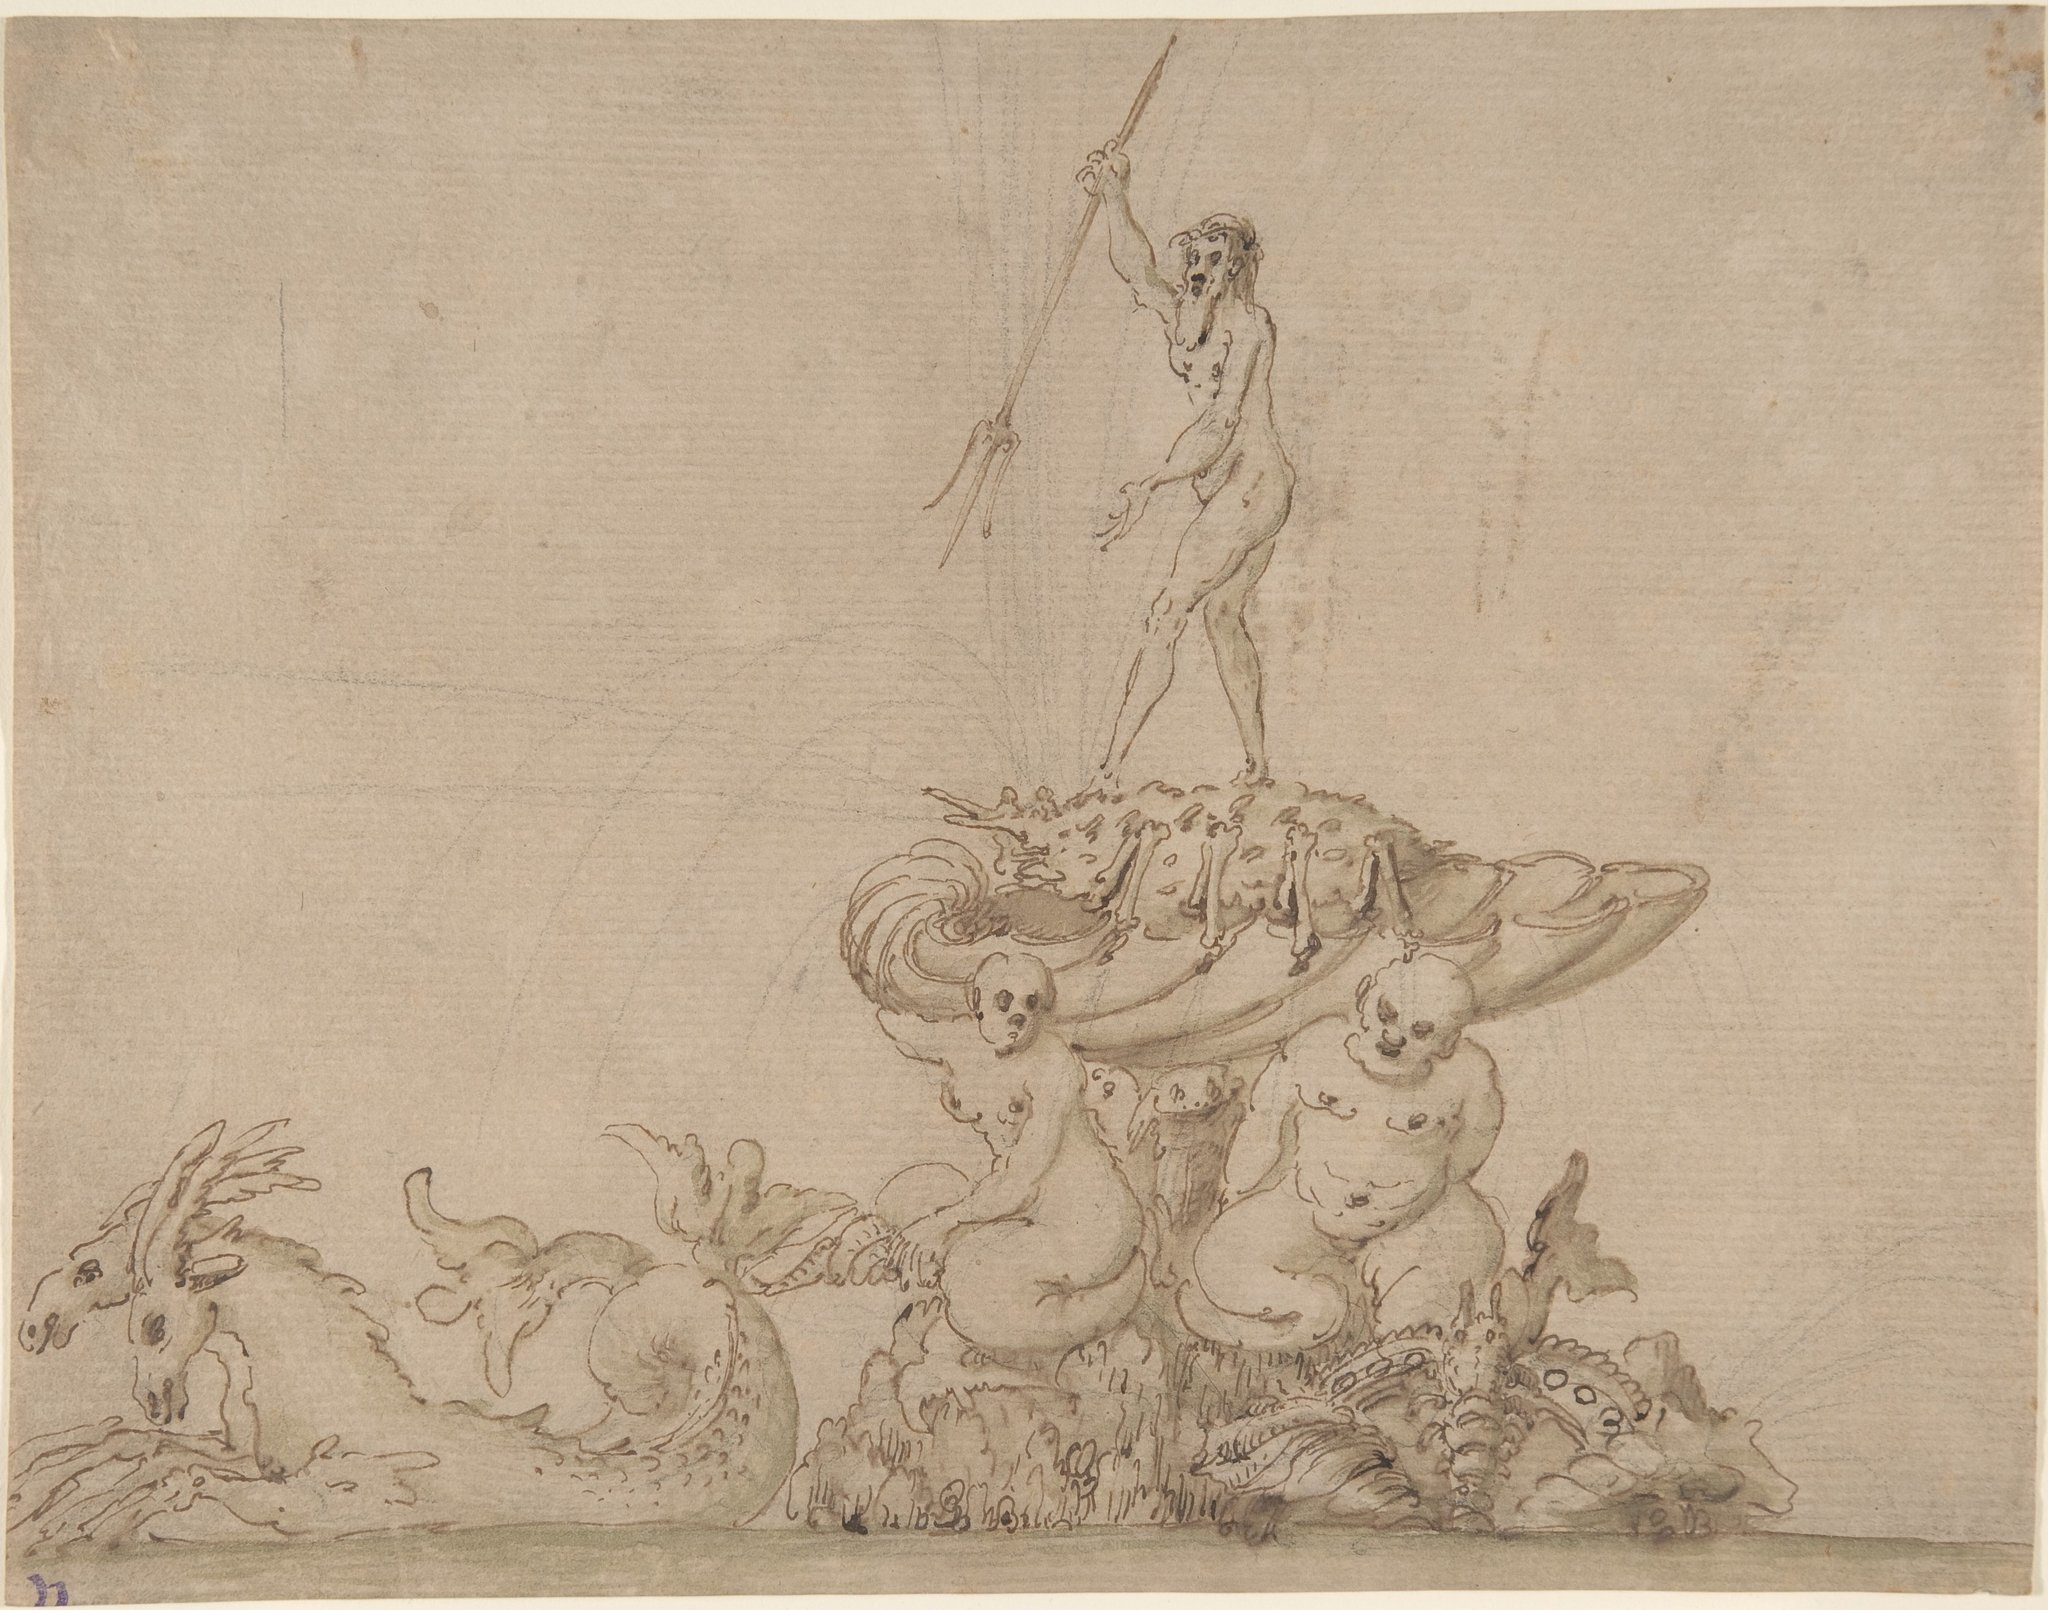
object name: drawing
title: Fountain with Neptune and Sea Creatures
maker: anonymous, italian, 17th century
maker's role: artist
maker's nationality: italian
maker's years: 1600-1700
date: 1601-1700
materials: ink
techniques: pen, wash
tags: fountains,neptune